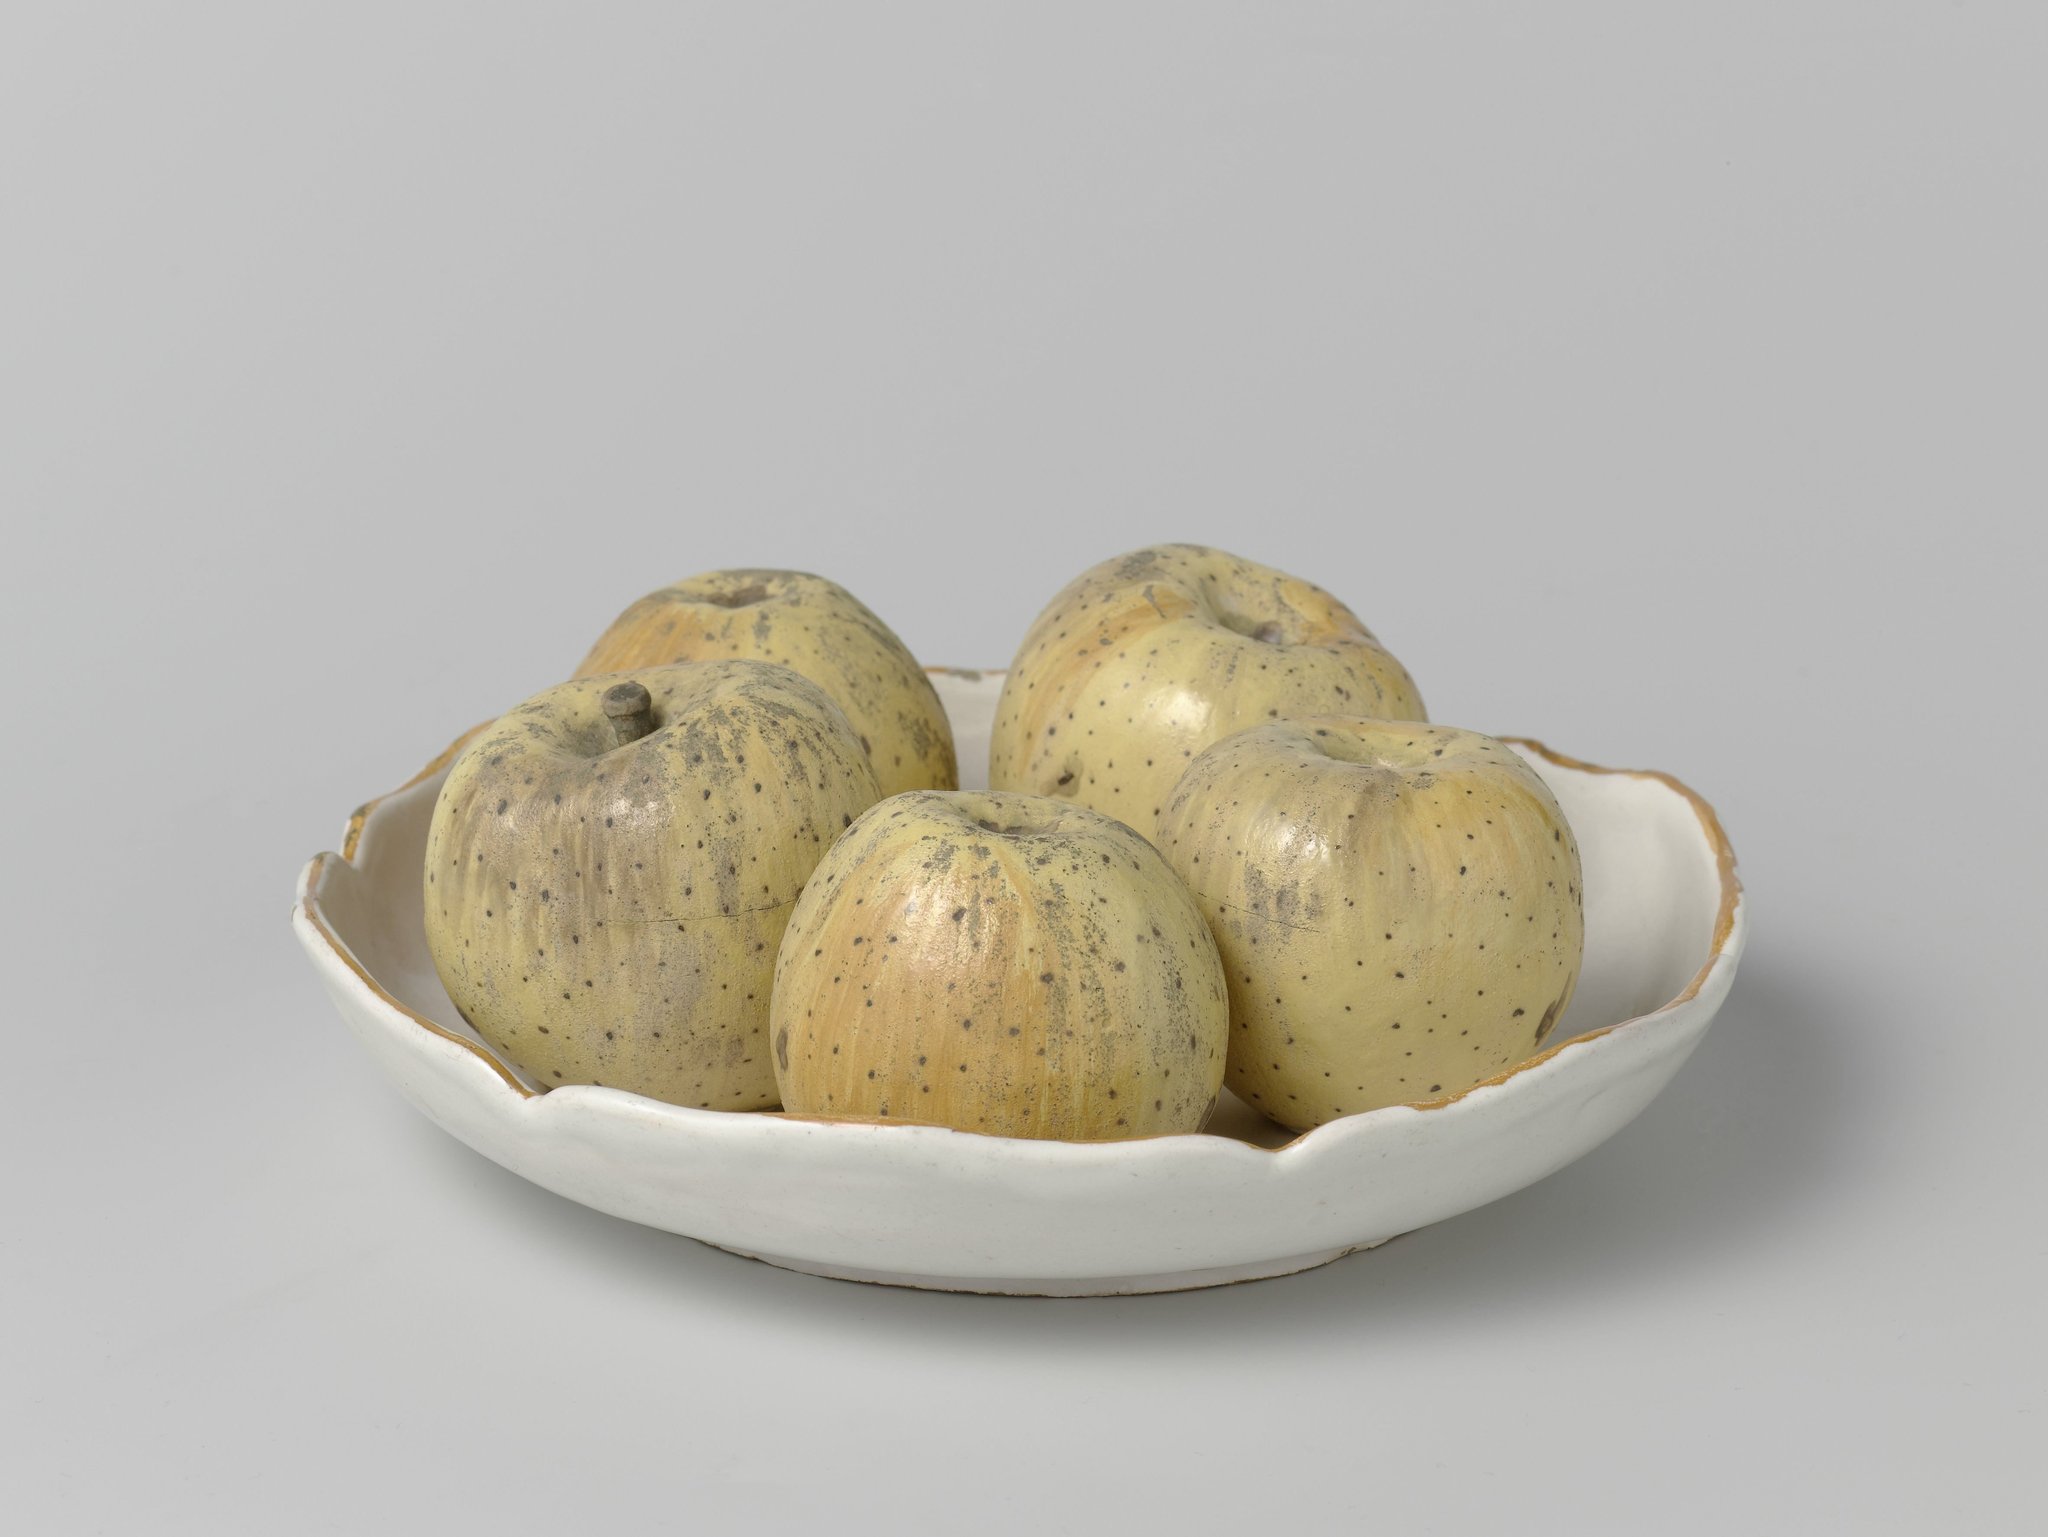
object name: decoratief object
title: Schotel met geschulpte rand en vijf opgelegde appels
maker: arie blankers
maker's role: plateelbakker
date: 1755-1760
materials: earthenware, glaze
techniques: painted, polychromy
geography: amsterdam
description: Ronde, witte schotel met appels, van veelkleurig beschilderde faience schotel heeft een geschulpte rand en op de schotel zijn vijf appels bevestigd.